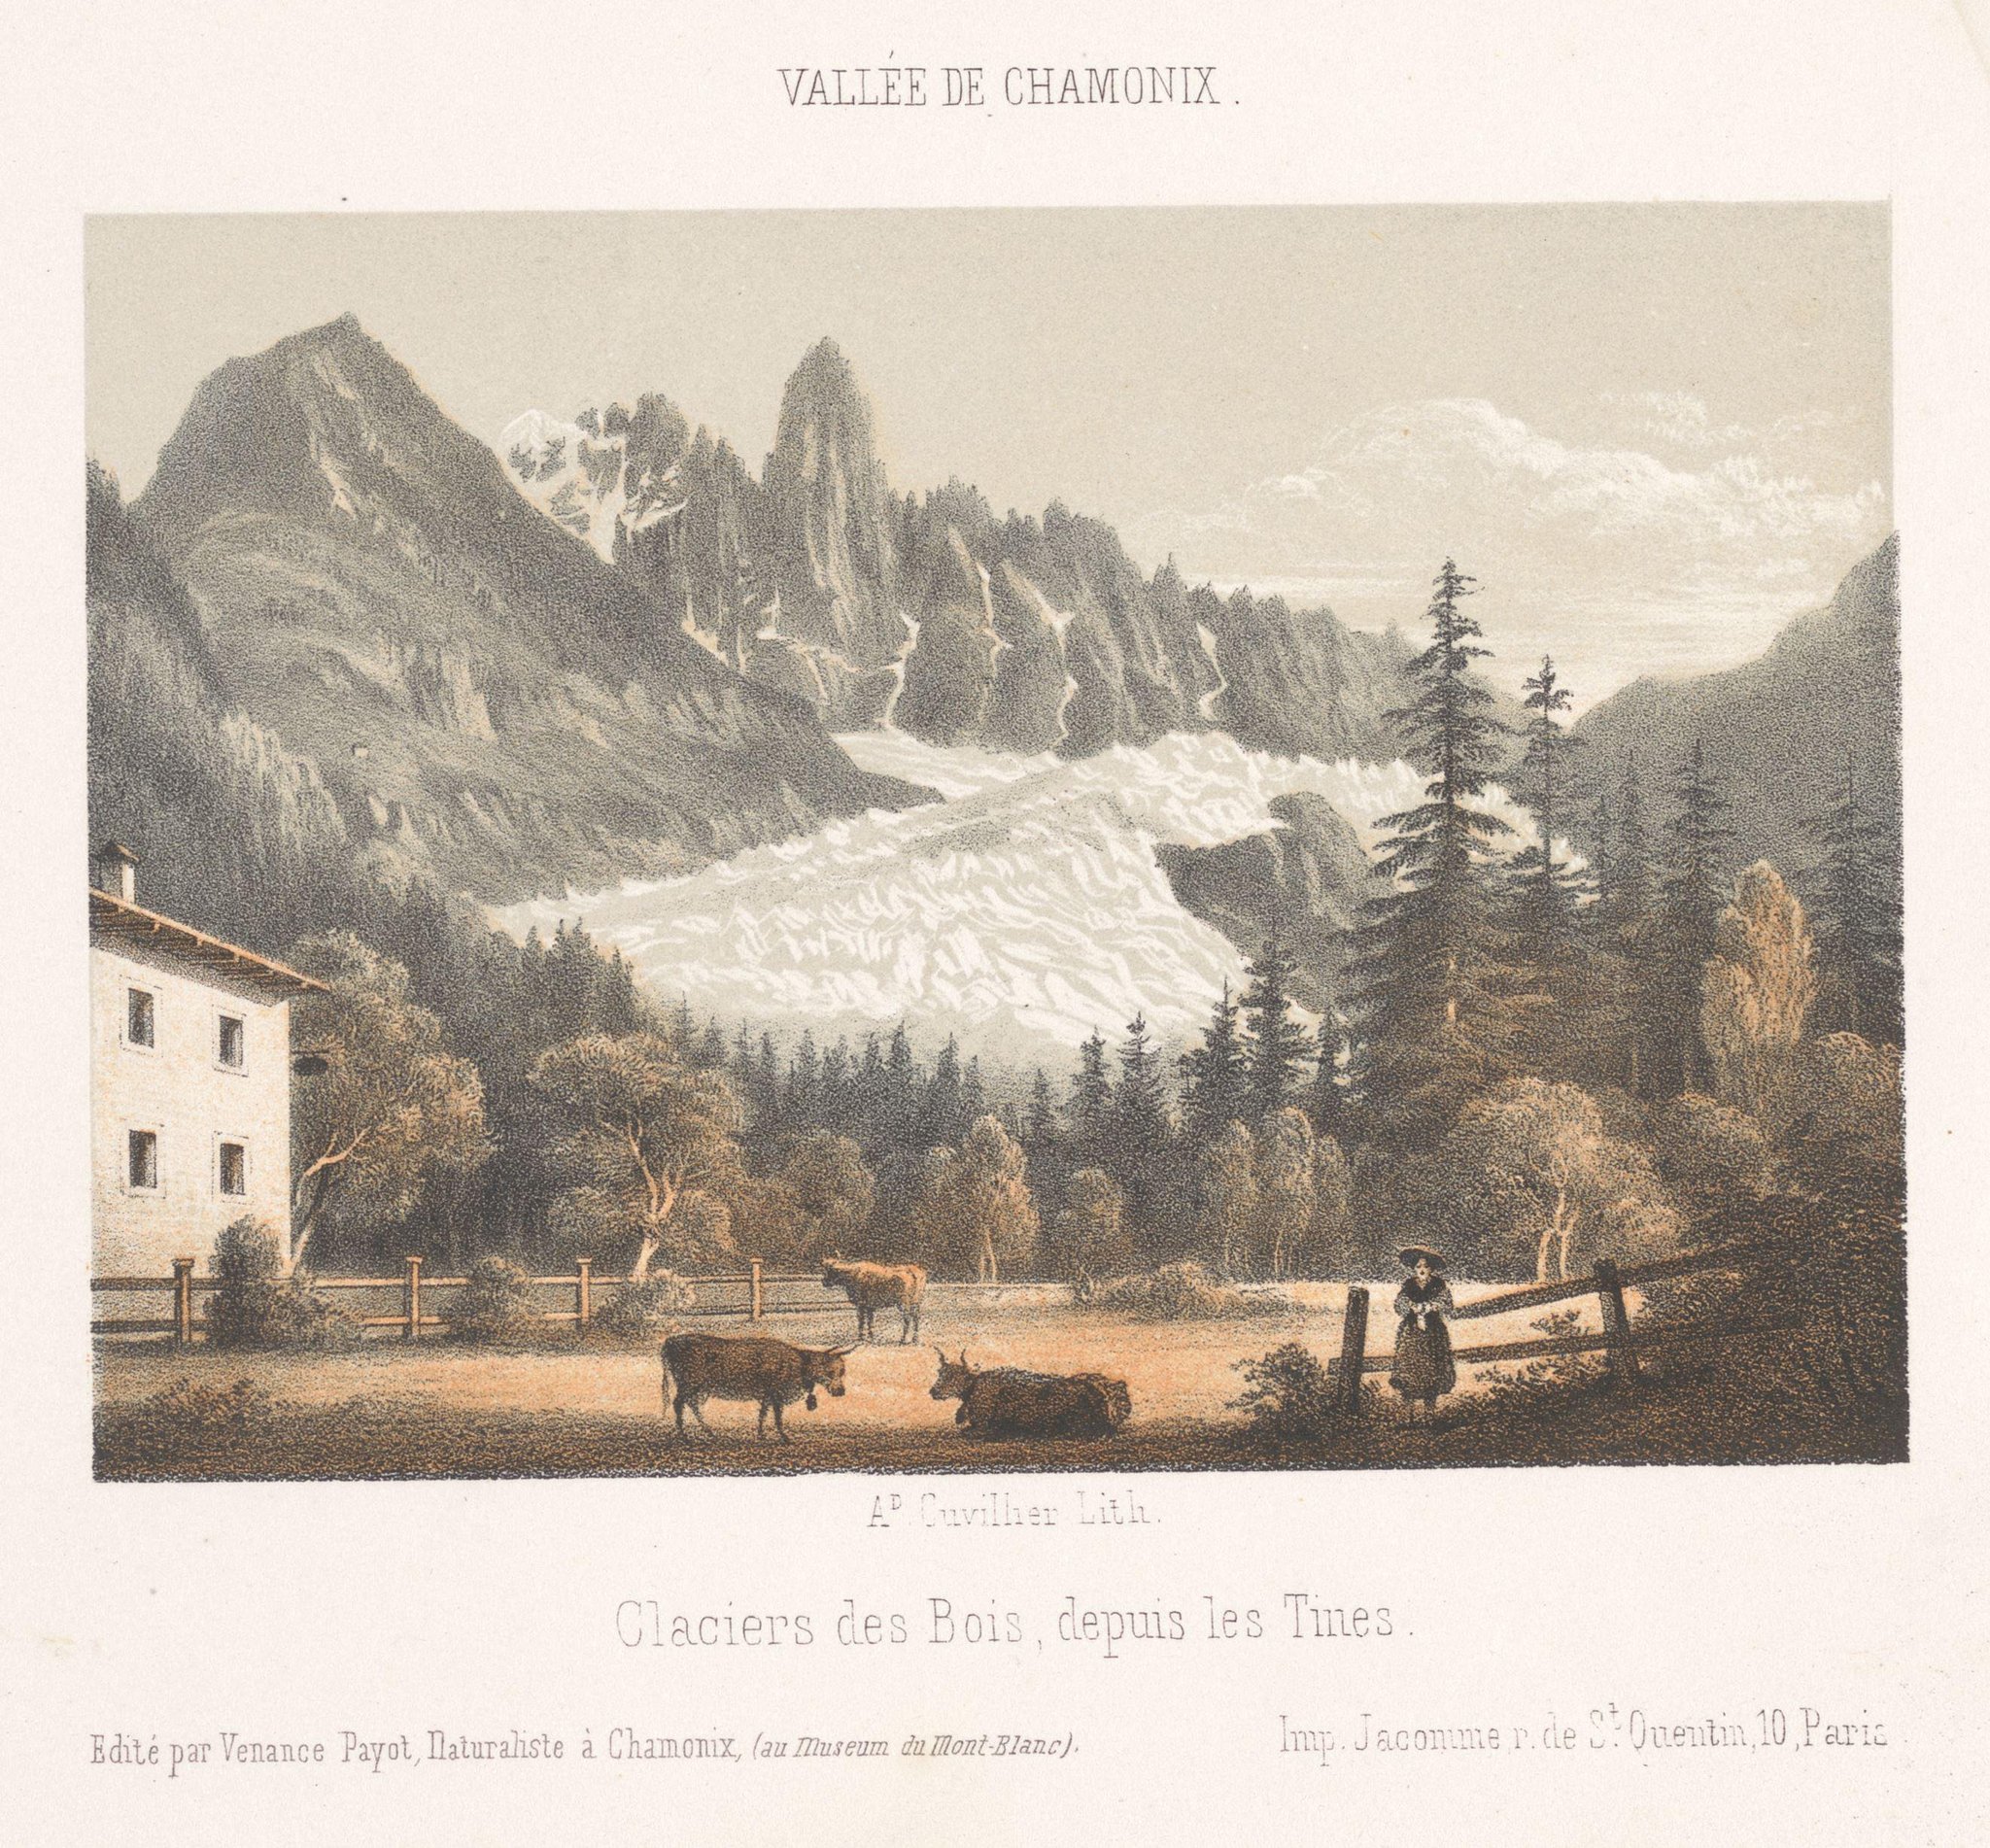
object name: print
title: Zicht op Chamonix en de Mont Blanc vanuit het noorden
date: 1858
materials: paper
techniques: lithograph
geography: paris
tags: mountain-range, snow peaks (+ landscape with figures, staffage), village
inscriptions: collector's mark: Lugt 2228a